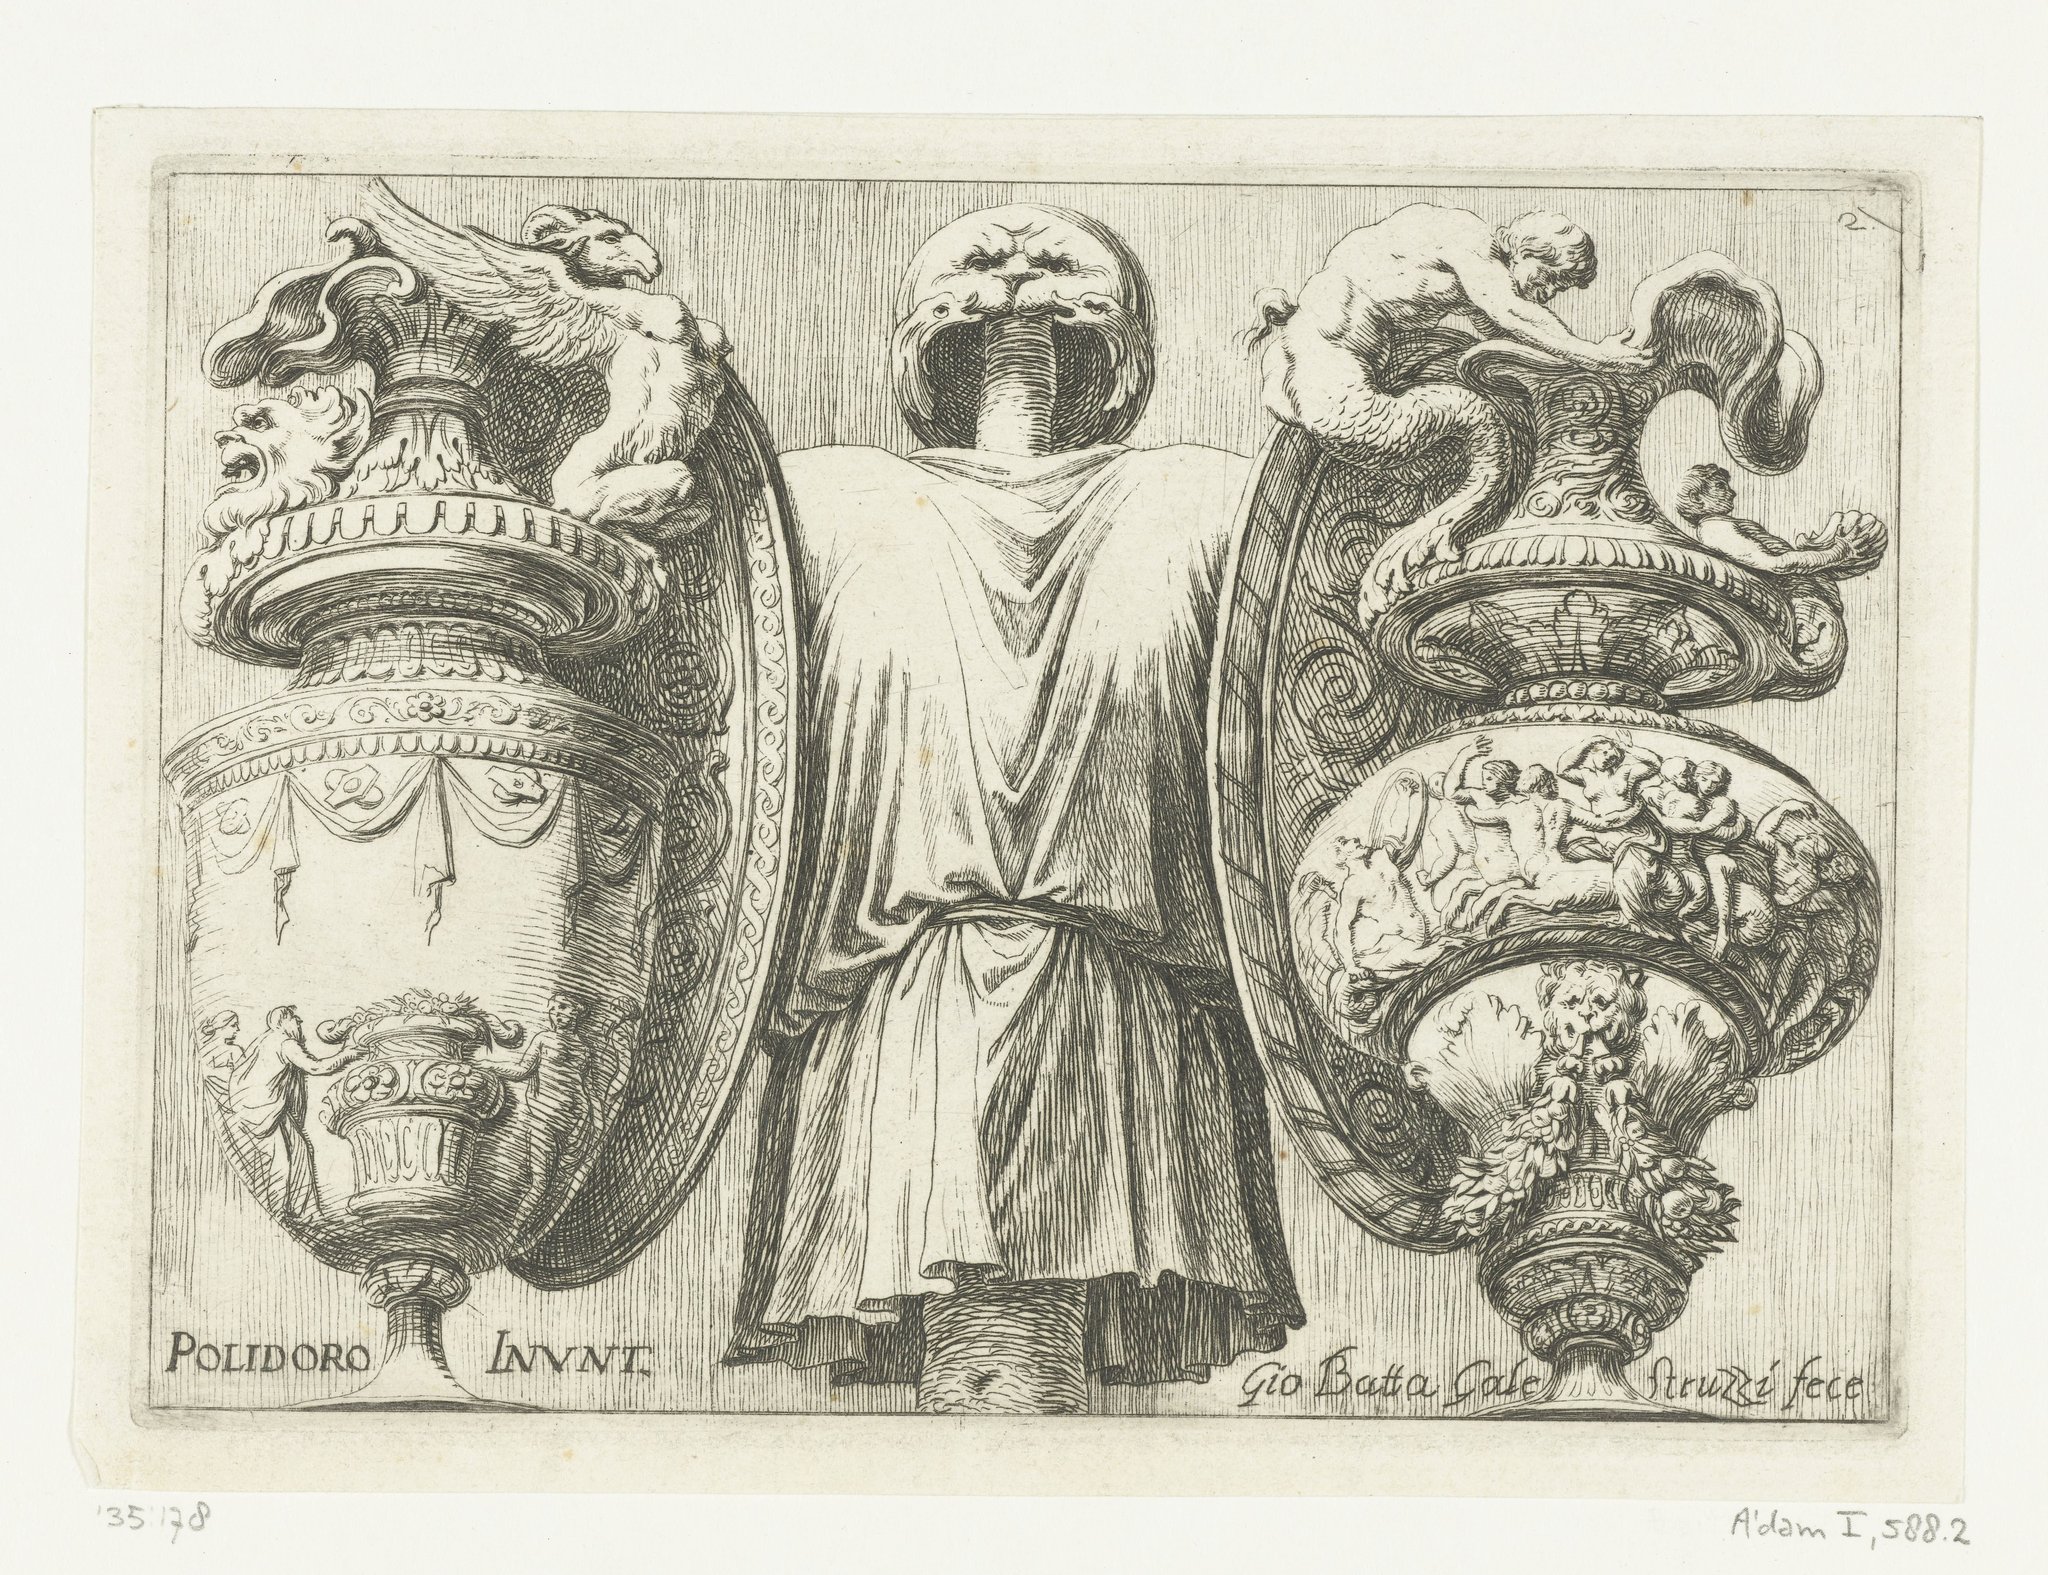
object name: ornament print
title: Opere di Polidoro da Caravaggi (...)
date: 1660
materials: paper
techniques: etching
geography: italy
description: Boomstronk met een tuniek en een helm in de vorm van een mascaron tussen twee schilden. Beide kannen hebben één oor, de linker in de vorm van een gevleugelde vrouwelijke sater met een bokkenkop.